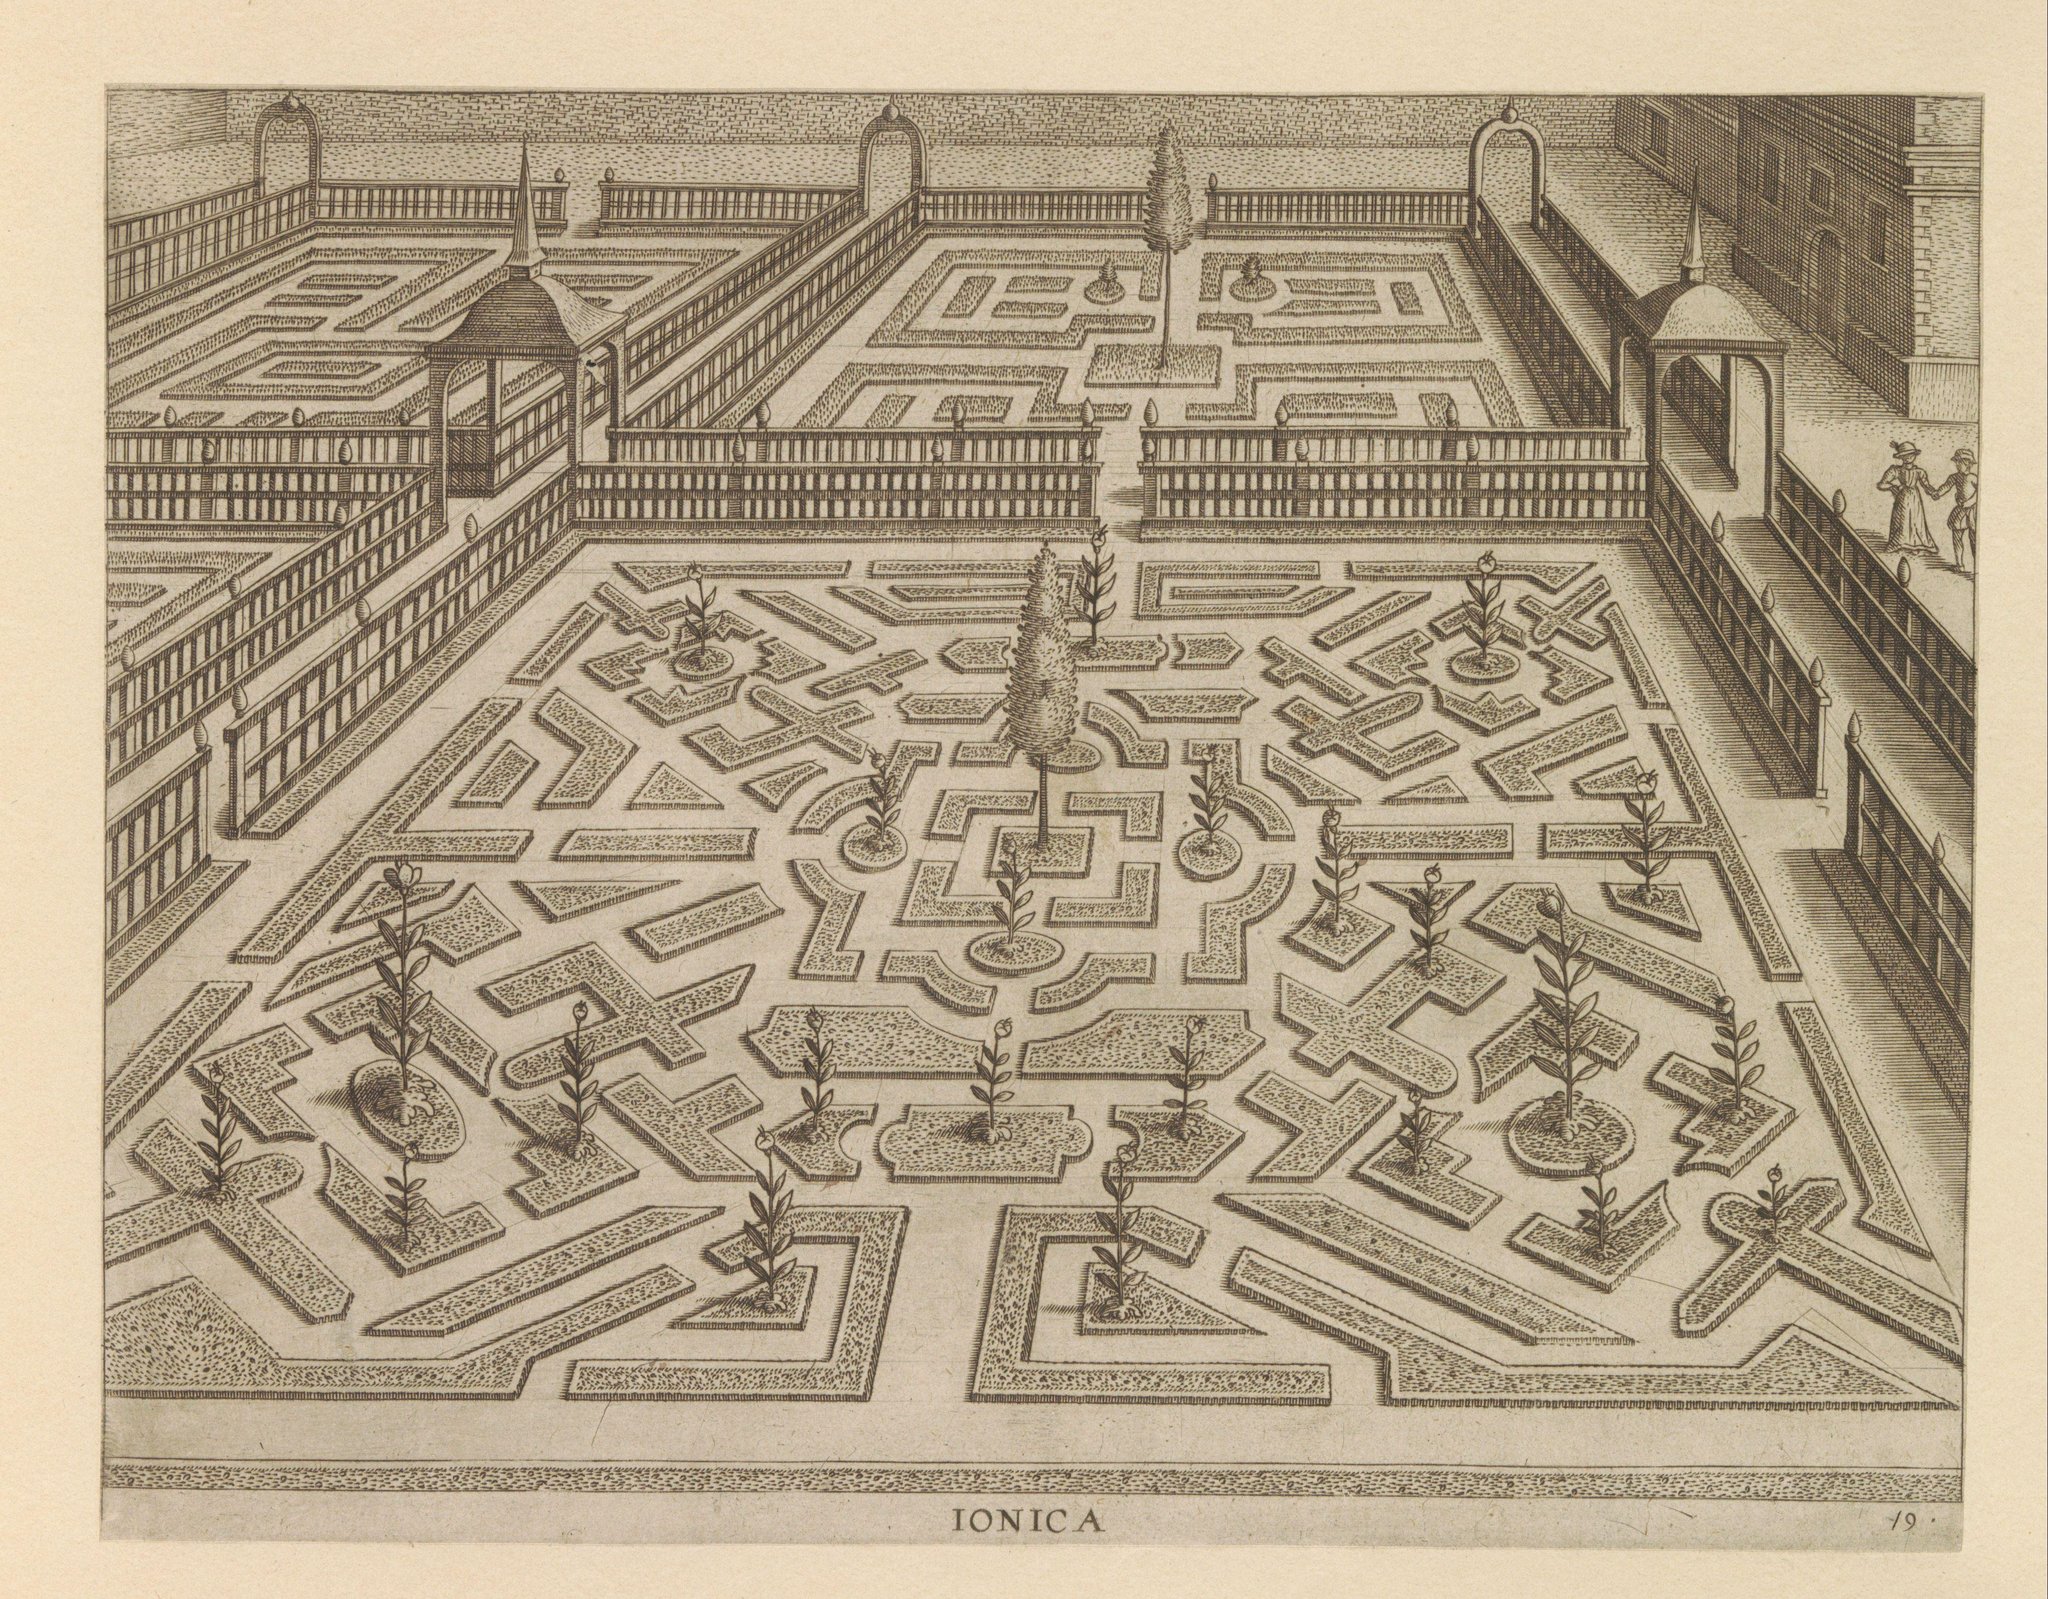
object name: album leaf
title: Tuinontwerpen geassocieerd met de Dorische, Ionische en Korinthische bouworden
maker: Anonymous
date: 1583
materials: paper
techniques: etching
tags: garden, french or architectonic garden; formal garden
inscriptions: inscription: ‘1’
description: Tuin met een parterre met in de diagonalen vierkante compartimenten en in de hoeken een kruis. De tuin is aangelegd volgens de Ionische bouworde. De prent maakt deel uit van een album.